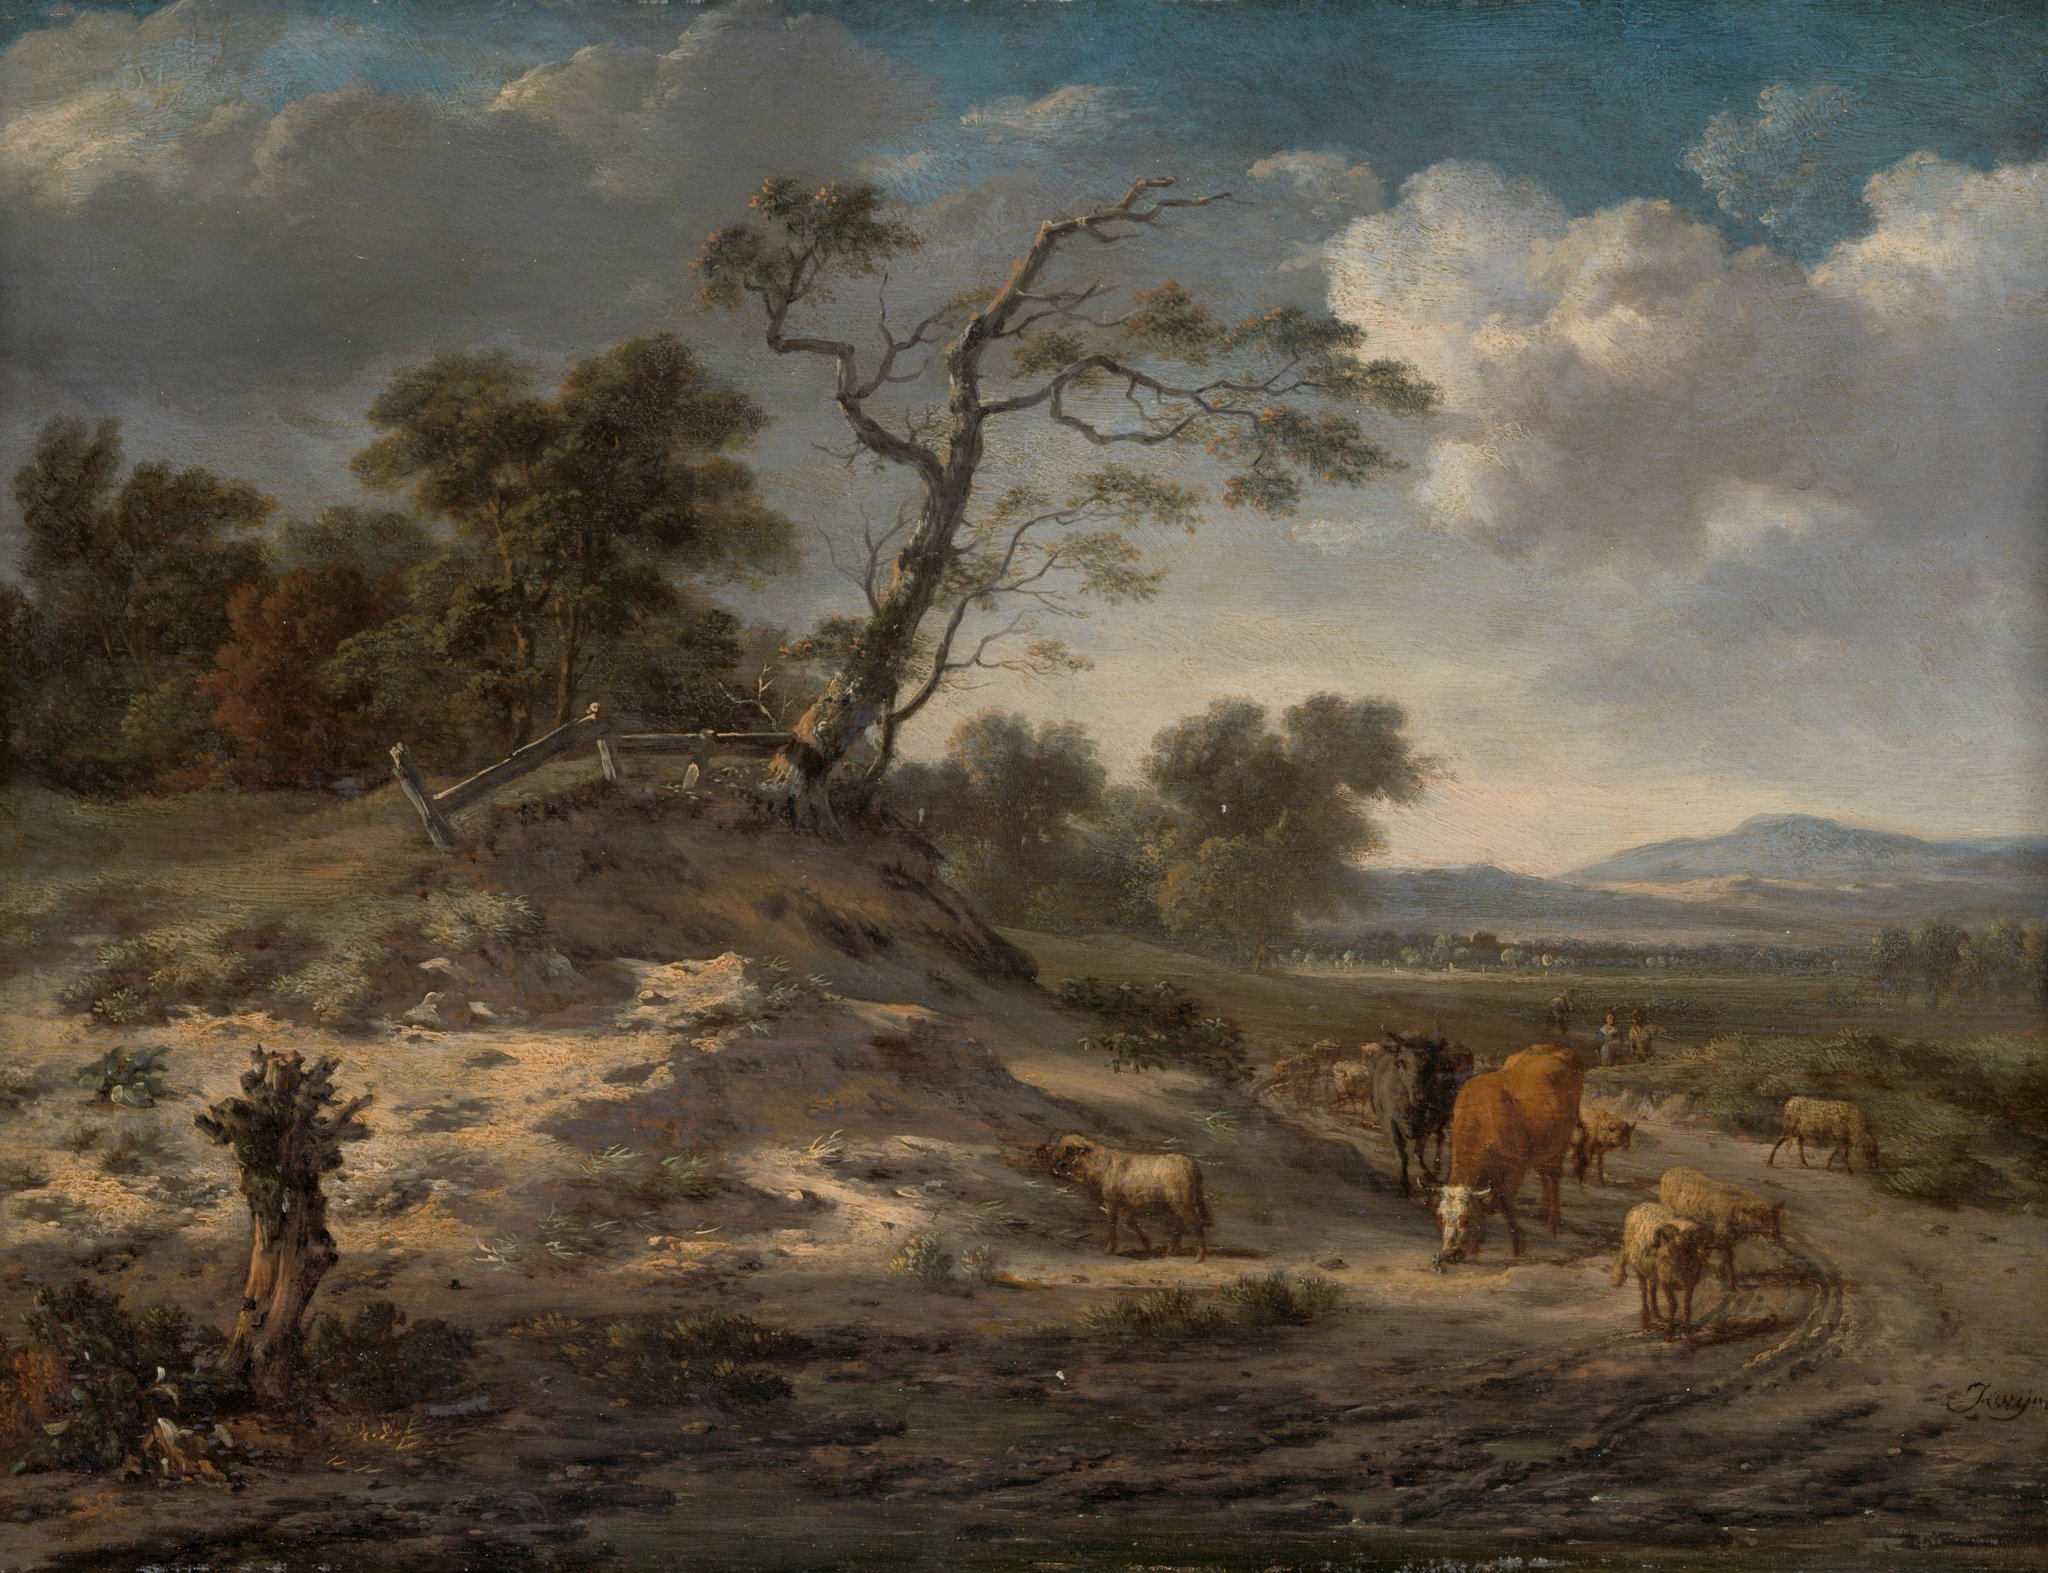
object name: painting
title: Landscape with Cattle on a Country Road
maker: jan wijnants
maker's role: draughtsman, painter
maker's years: 1632-1684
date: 1655-1684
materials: oil, panel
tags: herding, herdsman, herdswoman, shepherd, shepherdess, cowherd, etc., bovine cattle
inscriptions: signature: ‘J. Wijnants’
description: Landschap met duinen of zandheuvels waar koeien en schapen over een landweg gedreven worden.